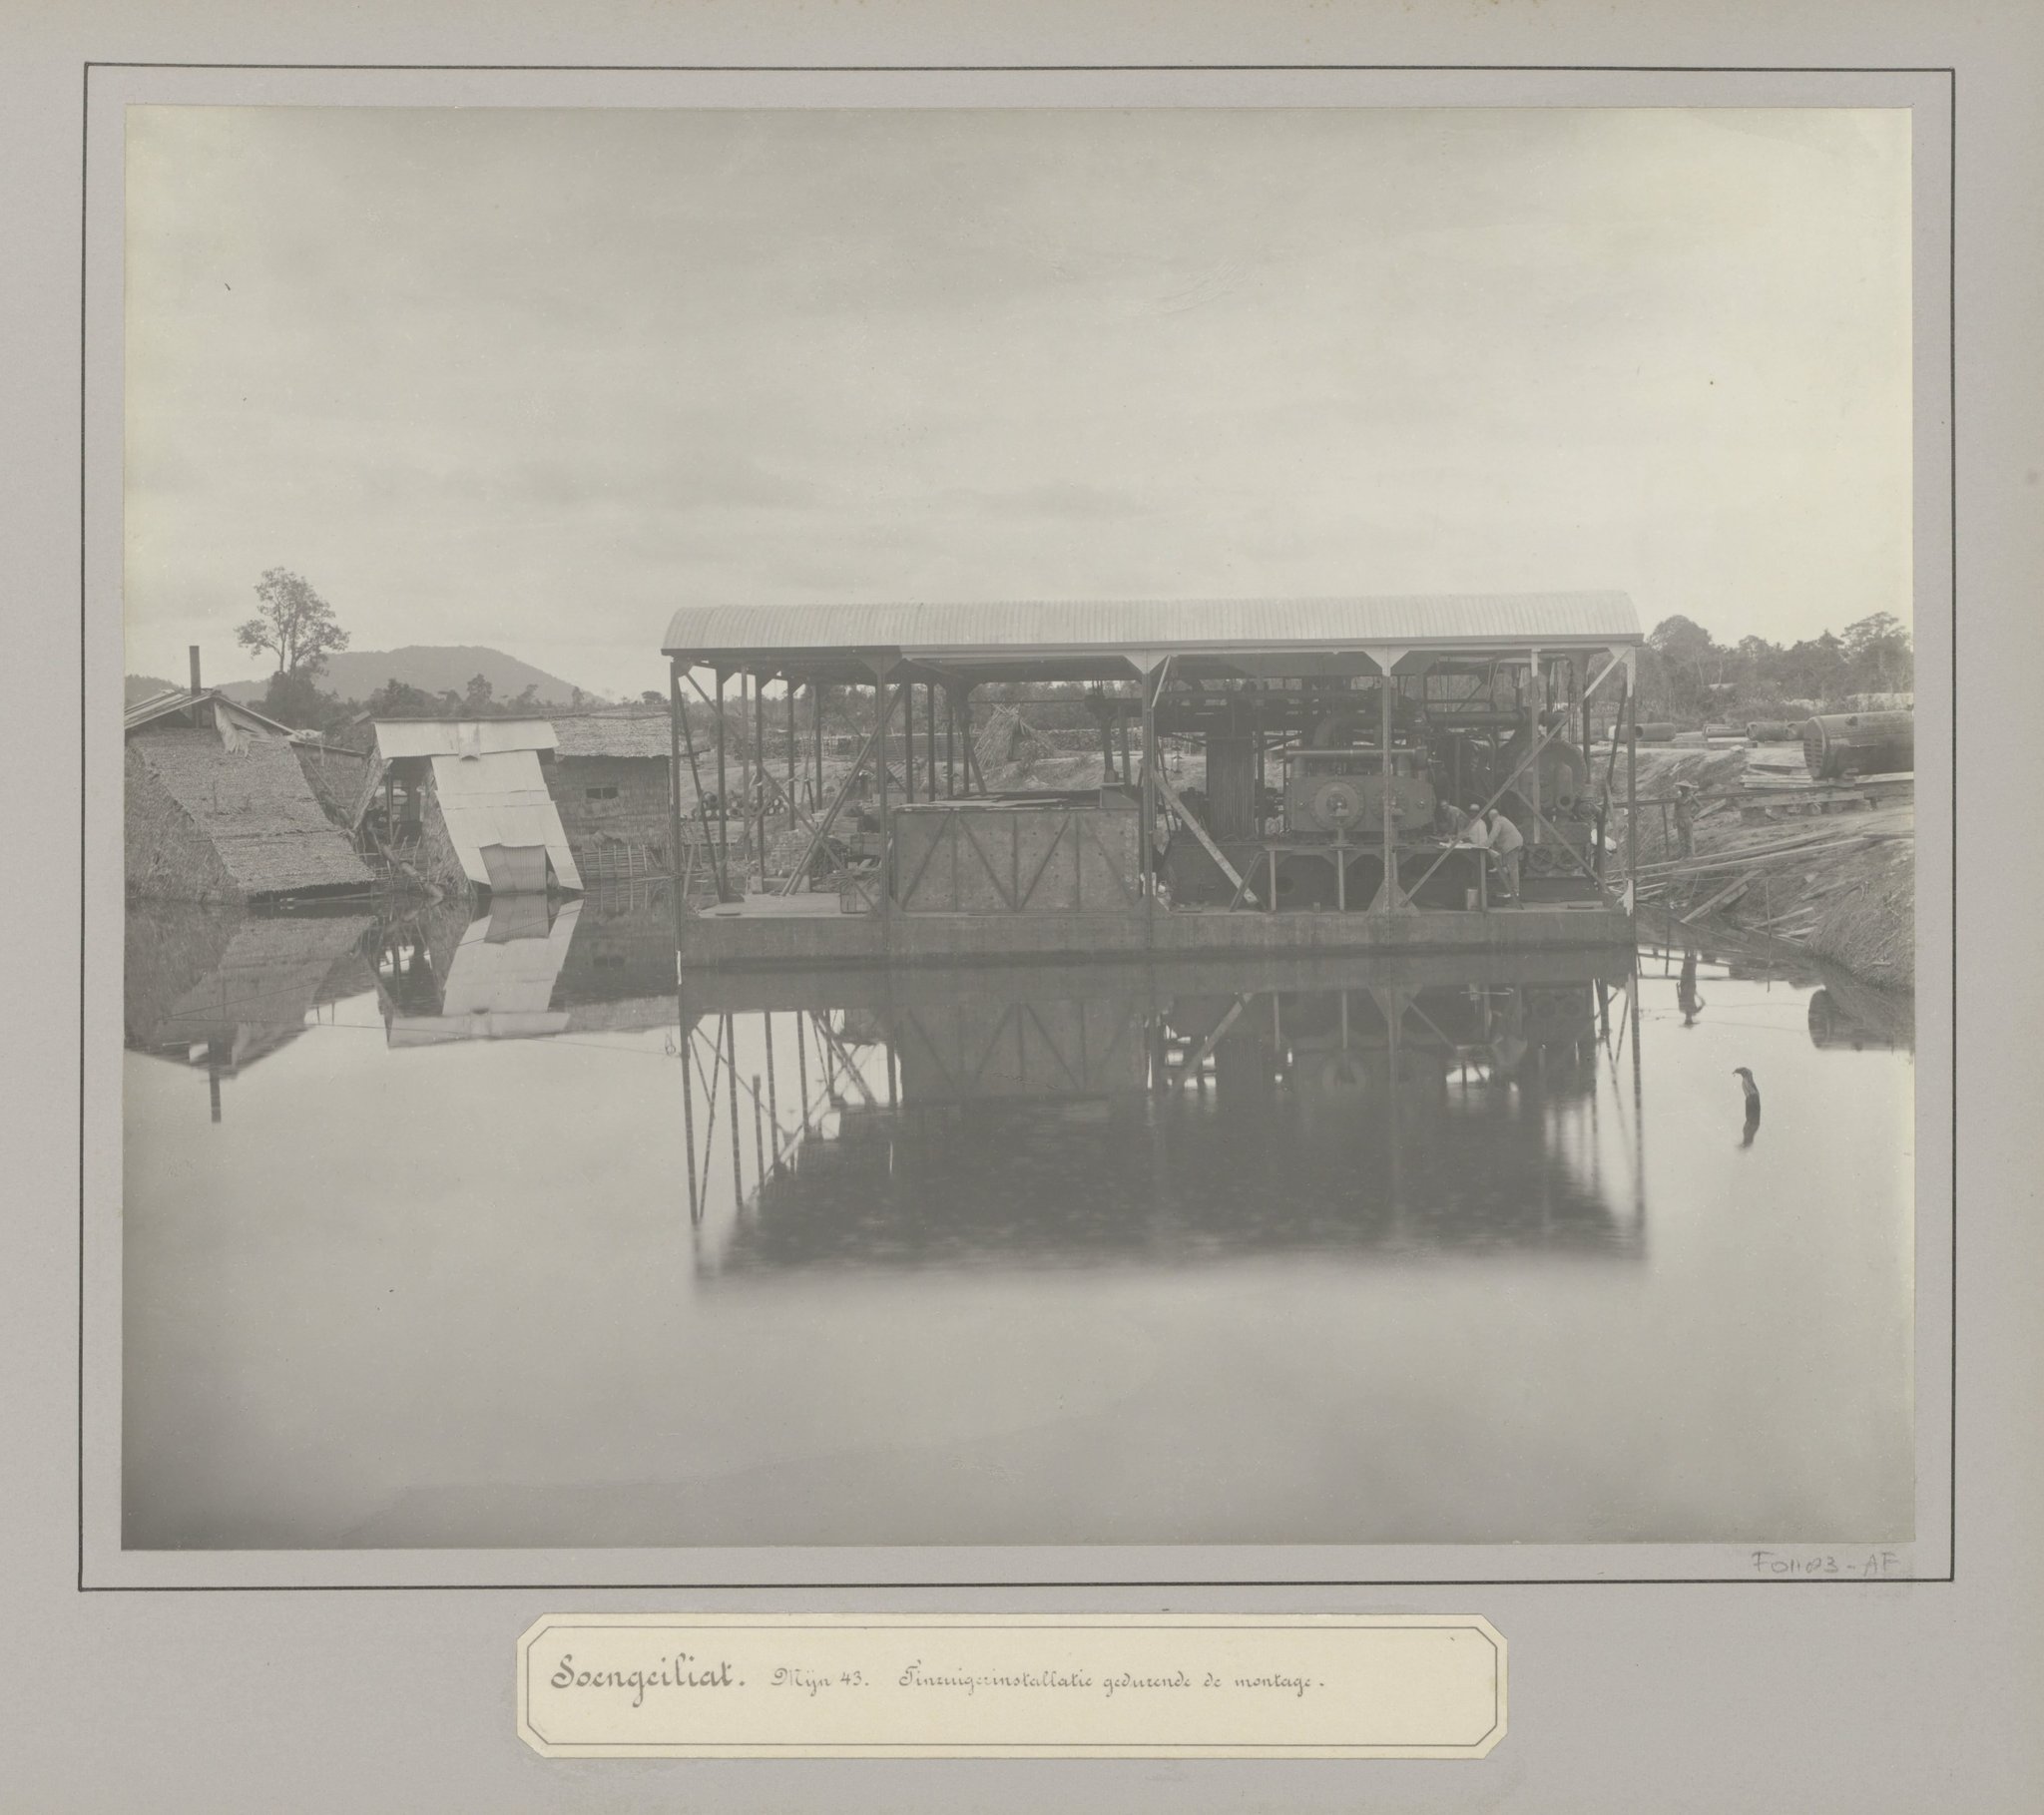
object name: photograph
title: Soengeiliat. Mijn 43. Tinzuigerinstallatie gedurende de montage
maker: Anonymous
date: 1900-1920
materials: photographic support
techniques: gelatin silver print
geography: soengeiliat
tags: mining, minerals and metals: tin, machines, engines ~ crafts and industries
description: Onderdeel van Fotoalbum over de tinwinning op Bangka.